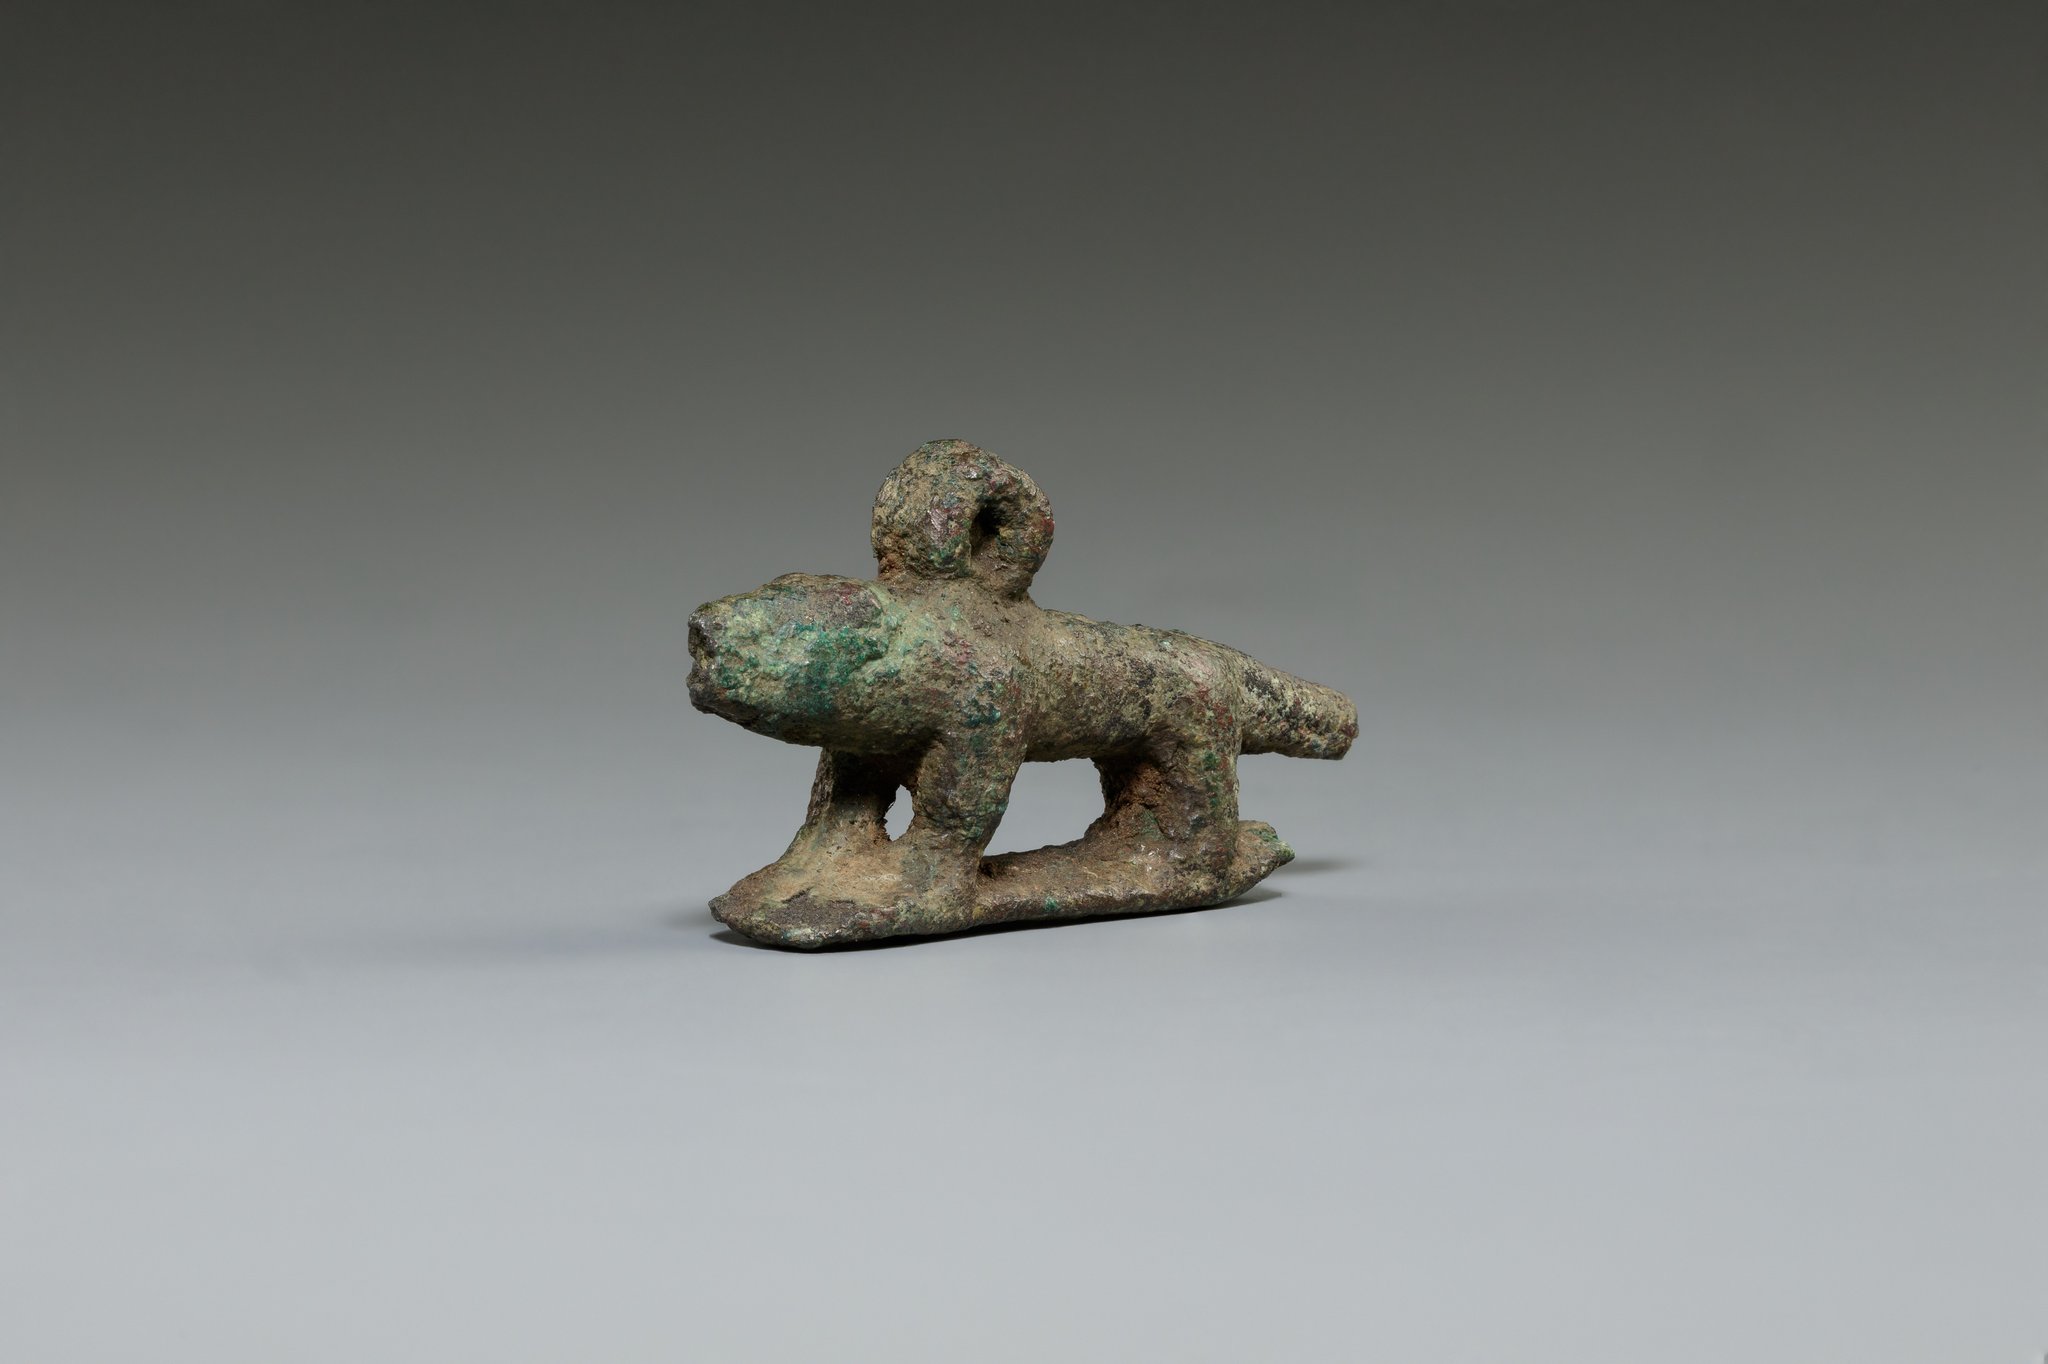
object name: amulet, ichneumon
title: Ichneumon with a thick loop on its back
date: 664-630 BCE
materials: alloy, bronze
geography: egypt